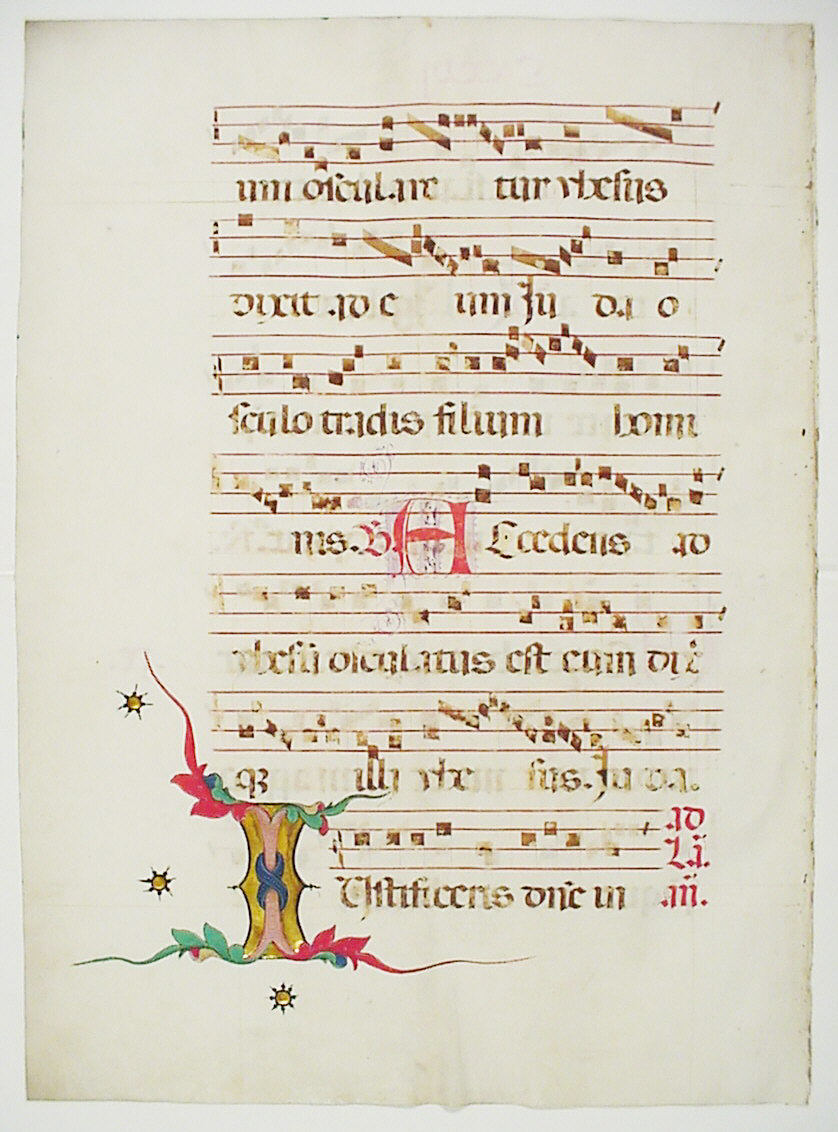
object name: antiphonary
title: Manuscript Leaf with Initial I, from an Antiphonary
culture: italian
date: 1401-1500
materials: ink, metal leaf, parchment, paint